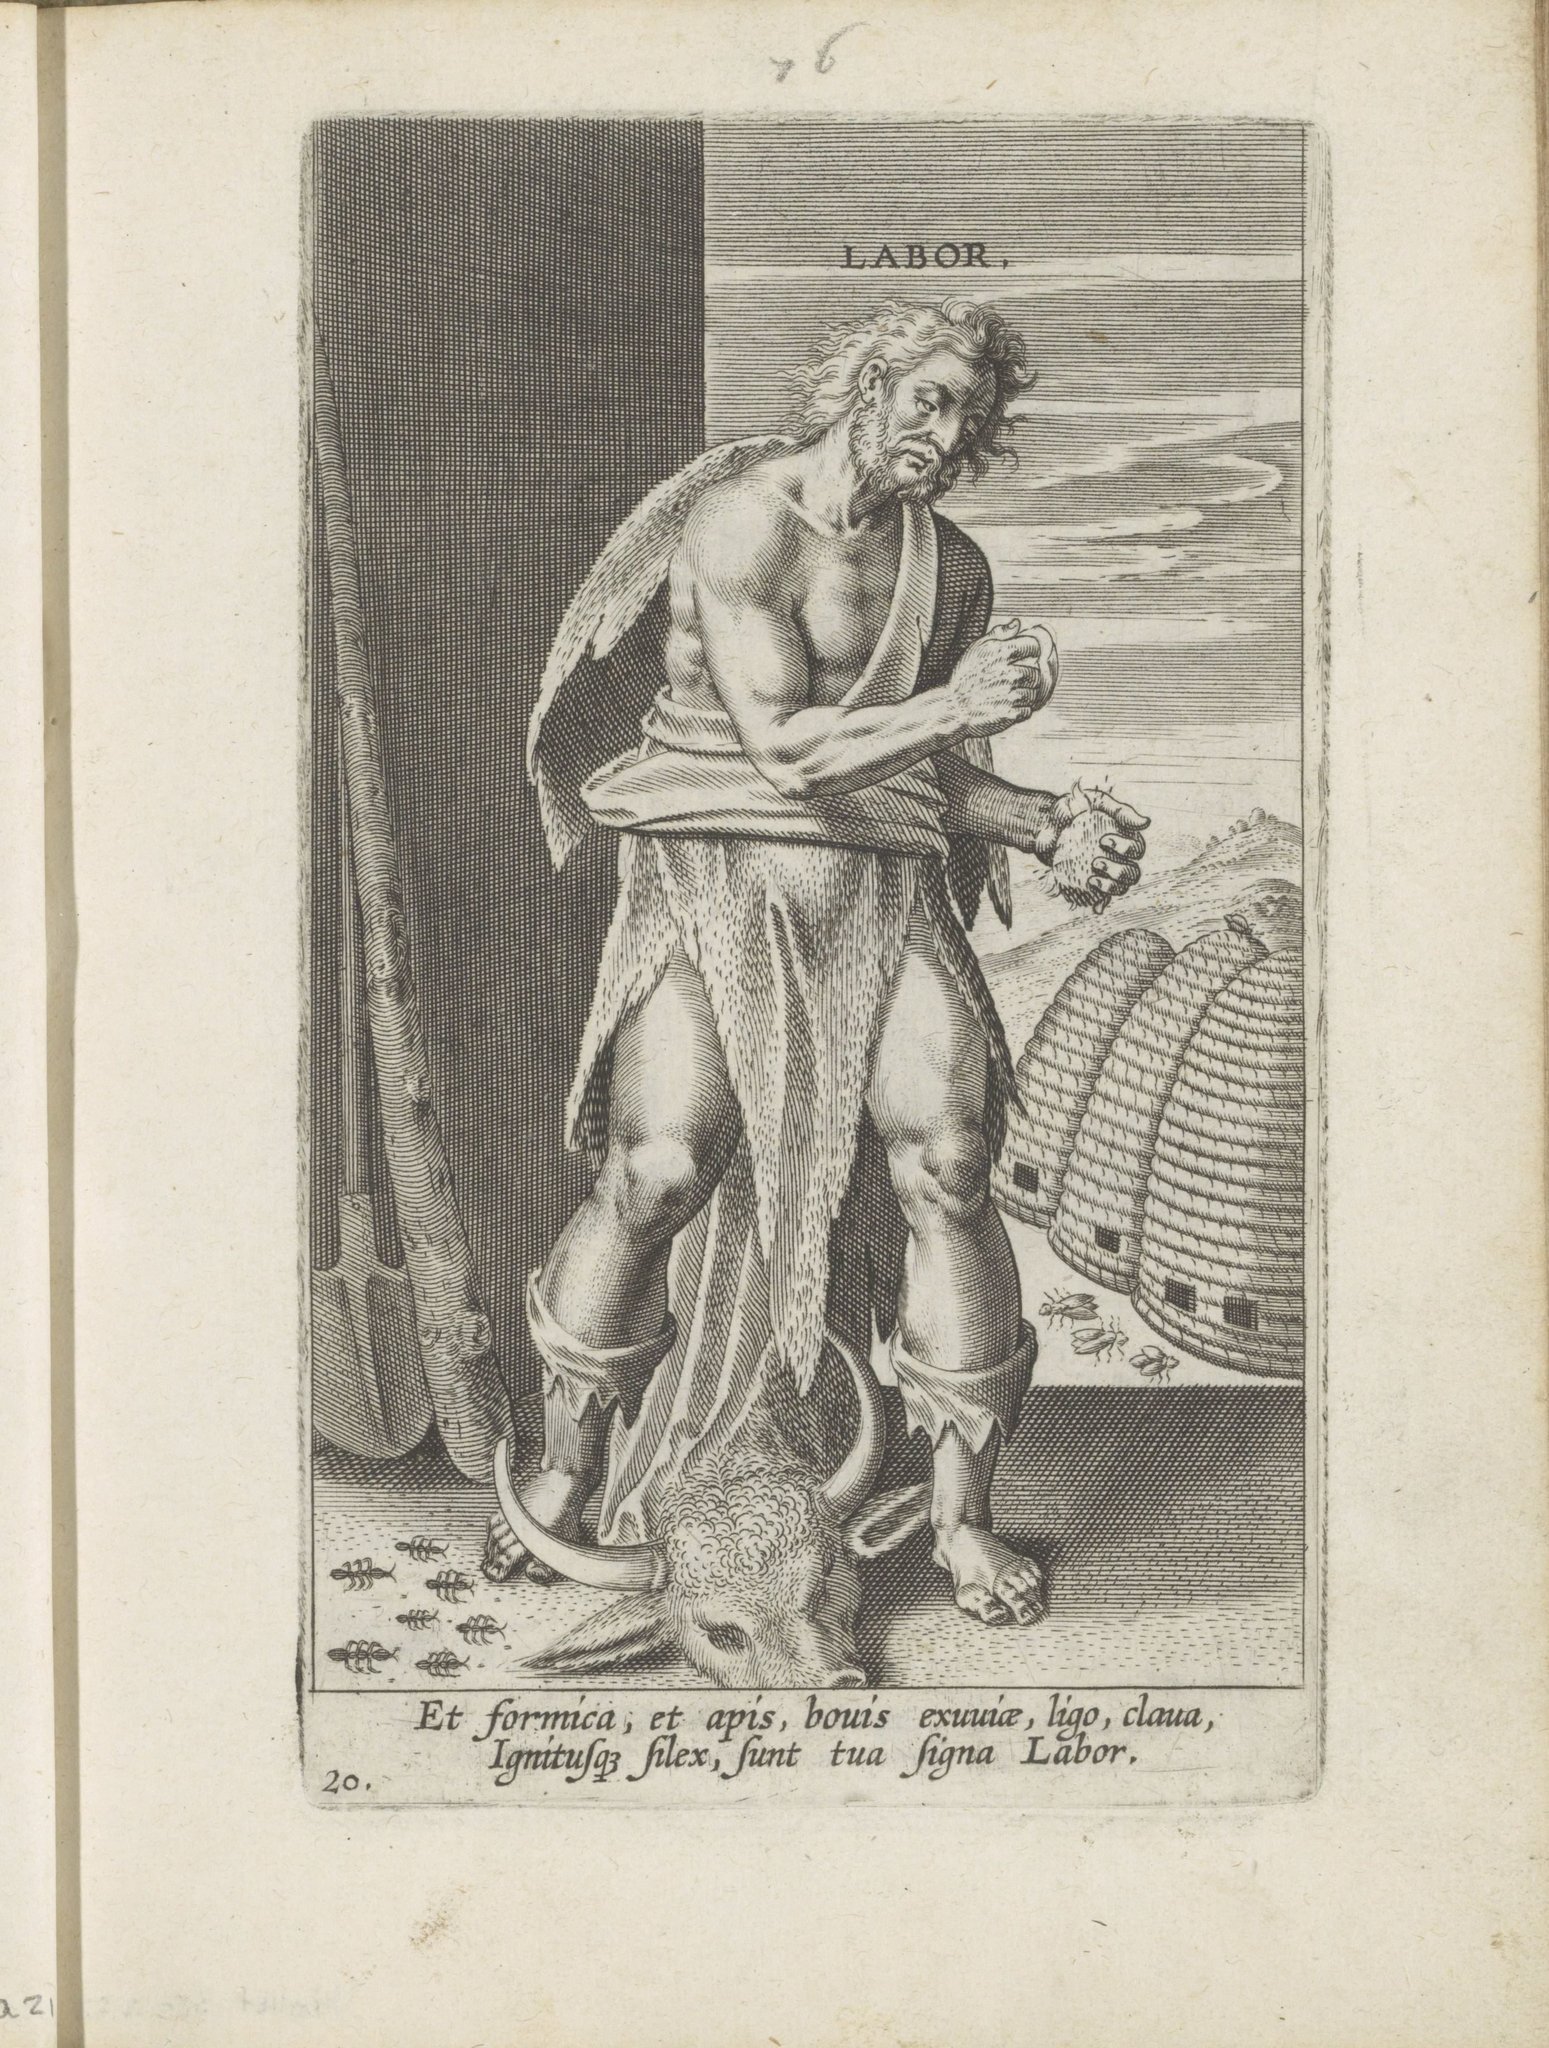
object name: album leaf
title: Prosopographia, sive virtutum, animi, corporis, bonorum externorum, vitiorum, et affectuum variorum delineatio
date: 1585-1590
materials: paper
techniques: engraving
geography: southern netherlands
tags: labour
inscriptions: collector's mark: Lugt 2228, collector's mark: Lugt 2760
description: Staande man gekleed in dierenhuid en vuurstenen in zijn handen. Aan zijn voeten een stierenkop en kruipende mieren. Links van de man een spade en een knuppel. Rechts drie bijenkorven. De bij en de mier zijn symbolen van vlijt en arbeid. Onder de voorstelling drie regels tekst in het Latijn. De prent maakt deel uit van een album.